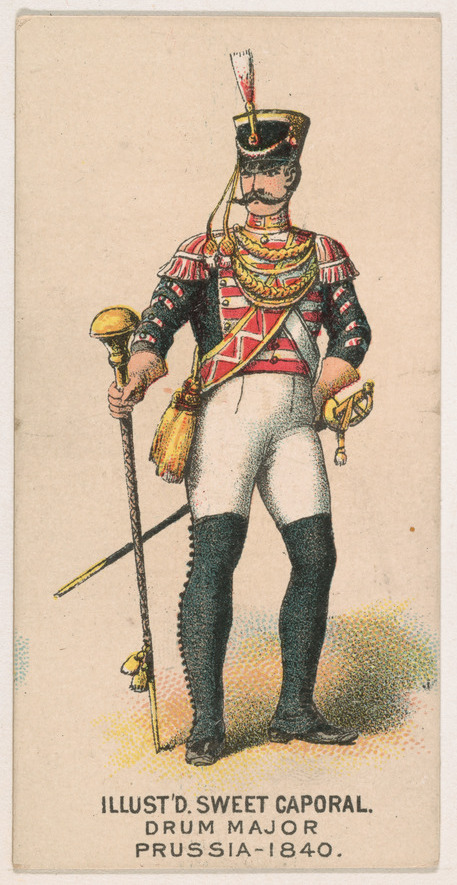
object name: print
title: Drum Major, Prussia, 1840, from the Military Series (N224) issued by Kinney Tobacco Company to promote Sweet Caporal Cigarettes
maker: kinney brothers tobacco company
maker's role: publisher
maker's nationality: american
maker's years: 1869-2011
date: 1888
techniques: color lithograph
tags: military,swords,men